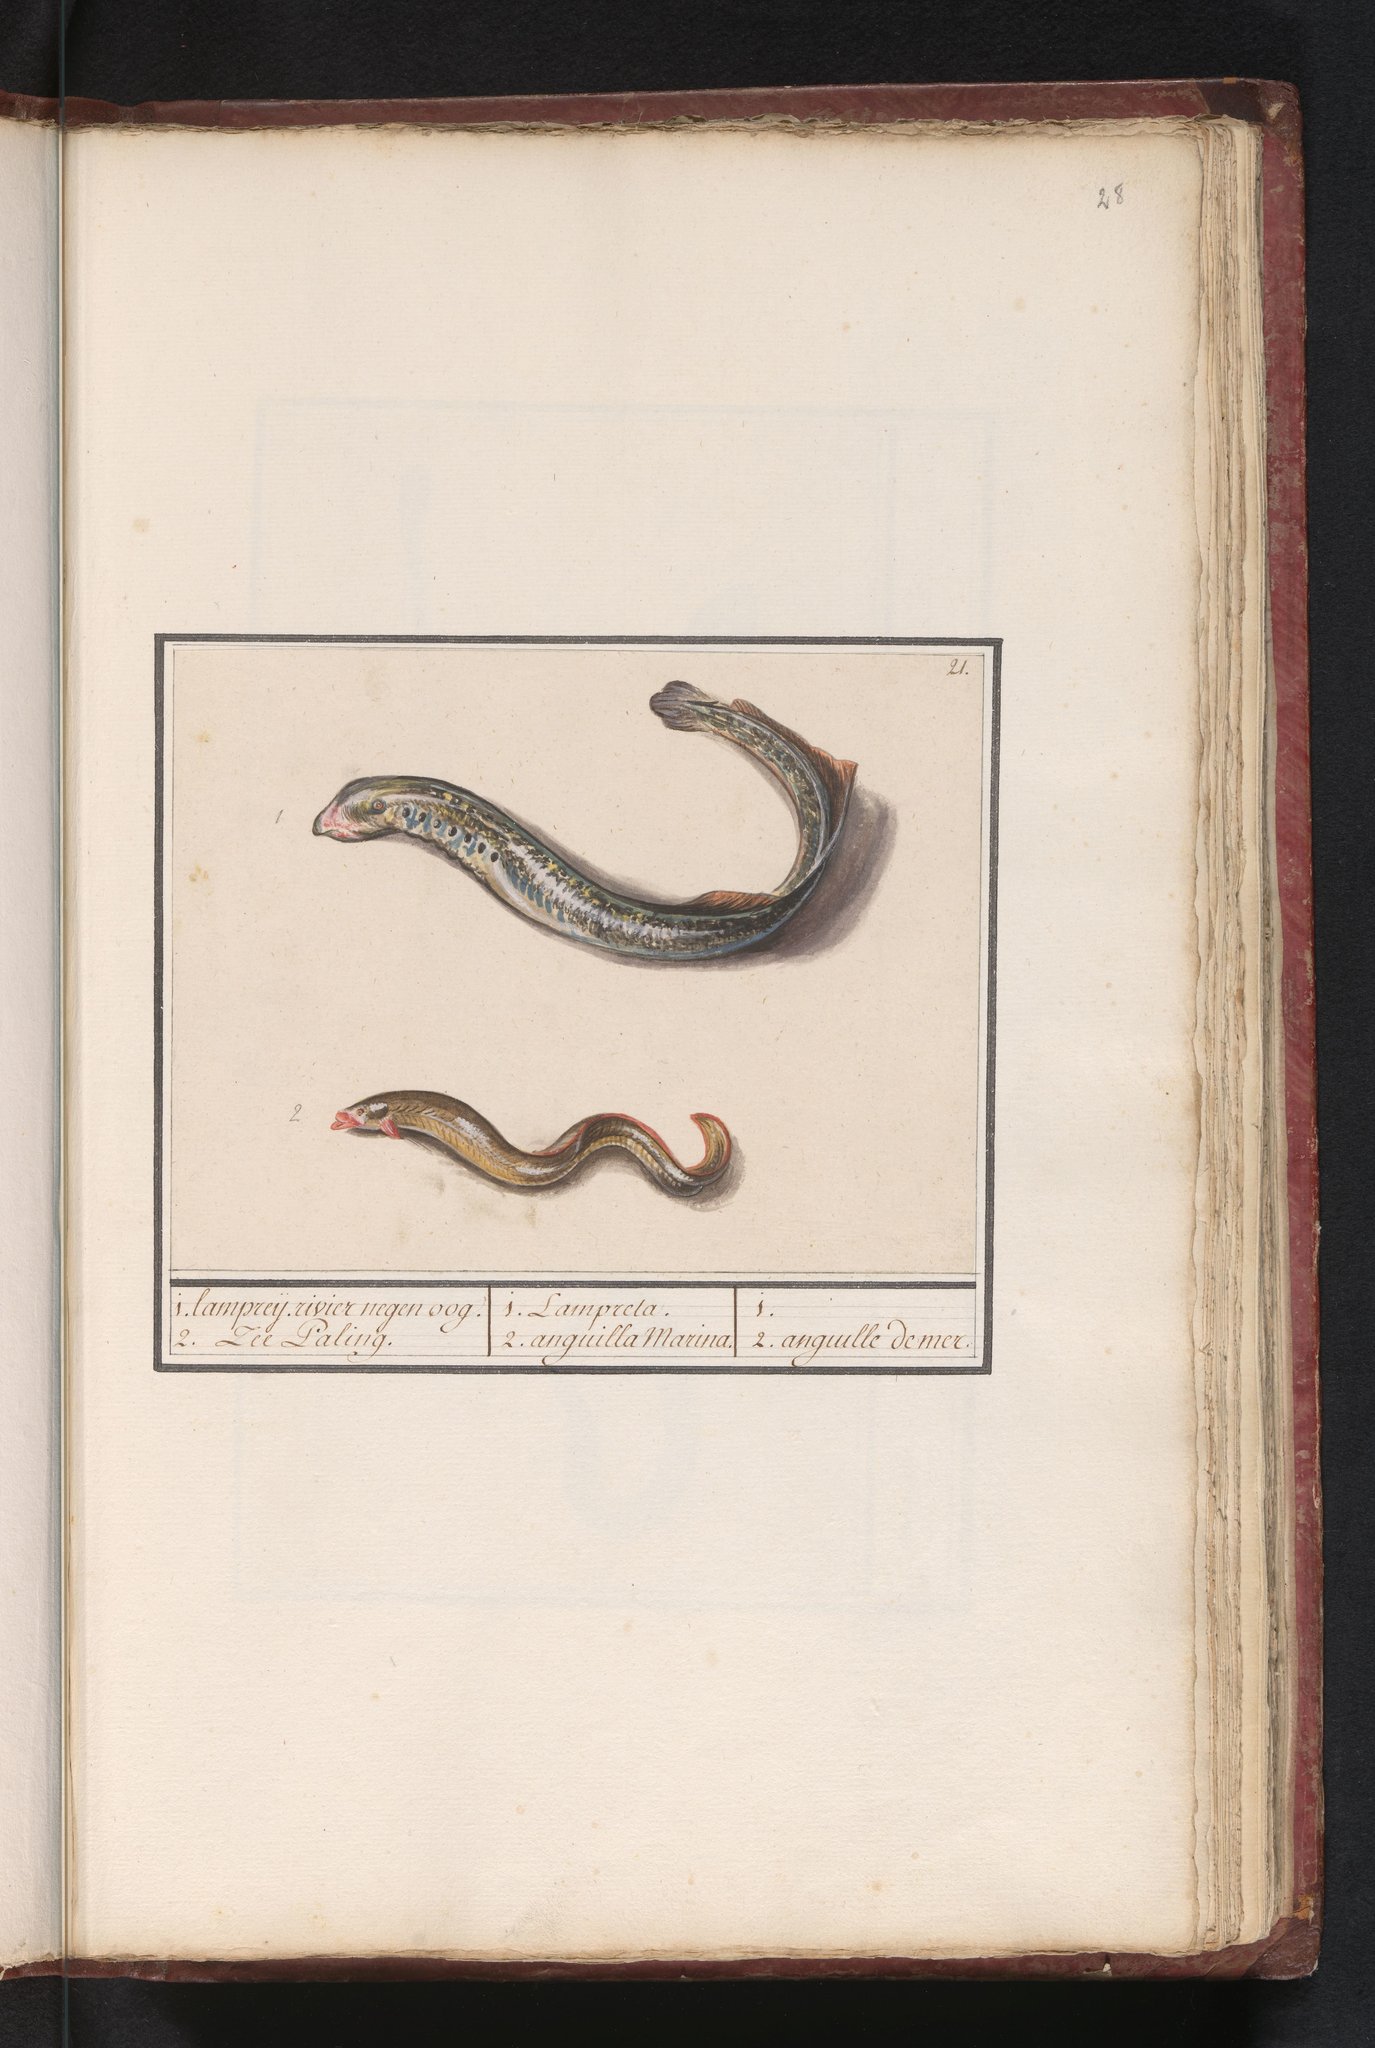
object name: drawing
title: 1. lampreij. rivier negen oog. 2. Zee Paling. / 1. Lampreta. 2. anguilla Marina. / 1. 2. anguille de mer.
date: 1596-1610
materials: chalk, paint, paper, pencil, watercolor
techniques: brush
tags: eels: eel, eels: lamprey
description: Rivierprik en zeepaling. Genummerd rechtsboven: 21. Onderdeel van het zesde album met tekeningen van vissen, schelpen en insekten. Zesde van twaalf albums met tekeningen van dieren, vogels en planten bekend rond 1600, gemaakt in opdracht van keizer Rudolf II. Met toelichting in Nederlands, Latijn en Frans.